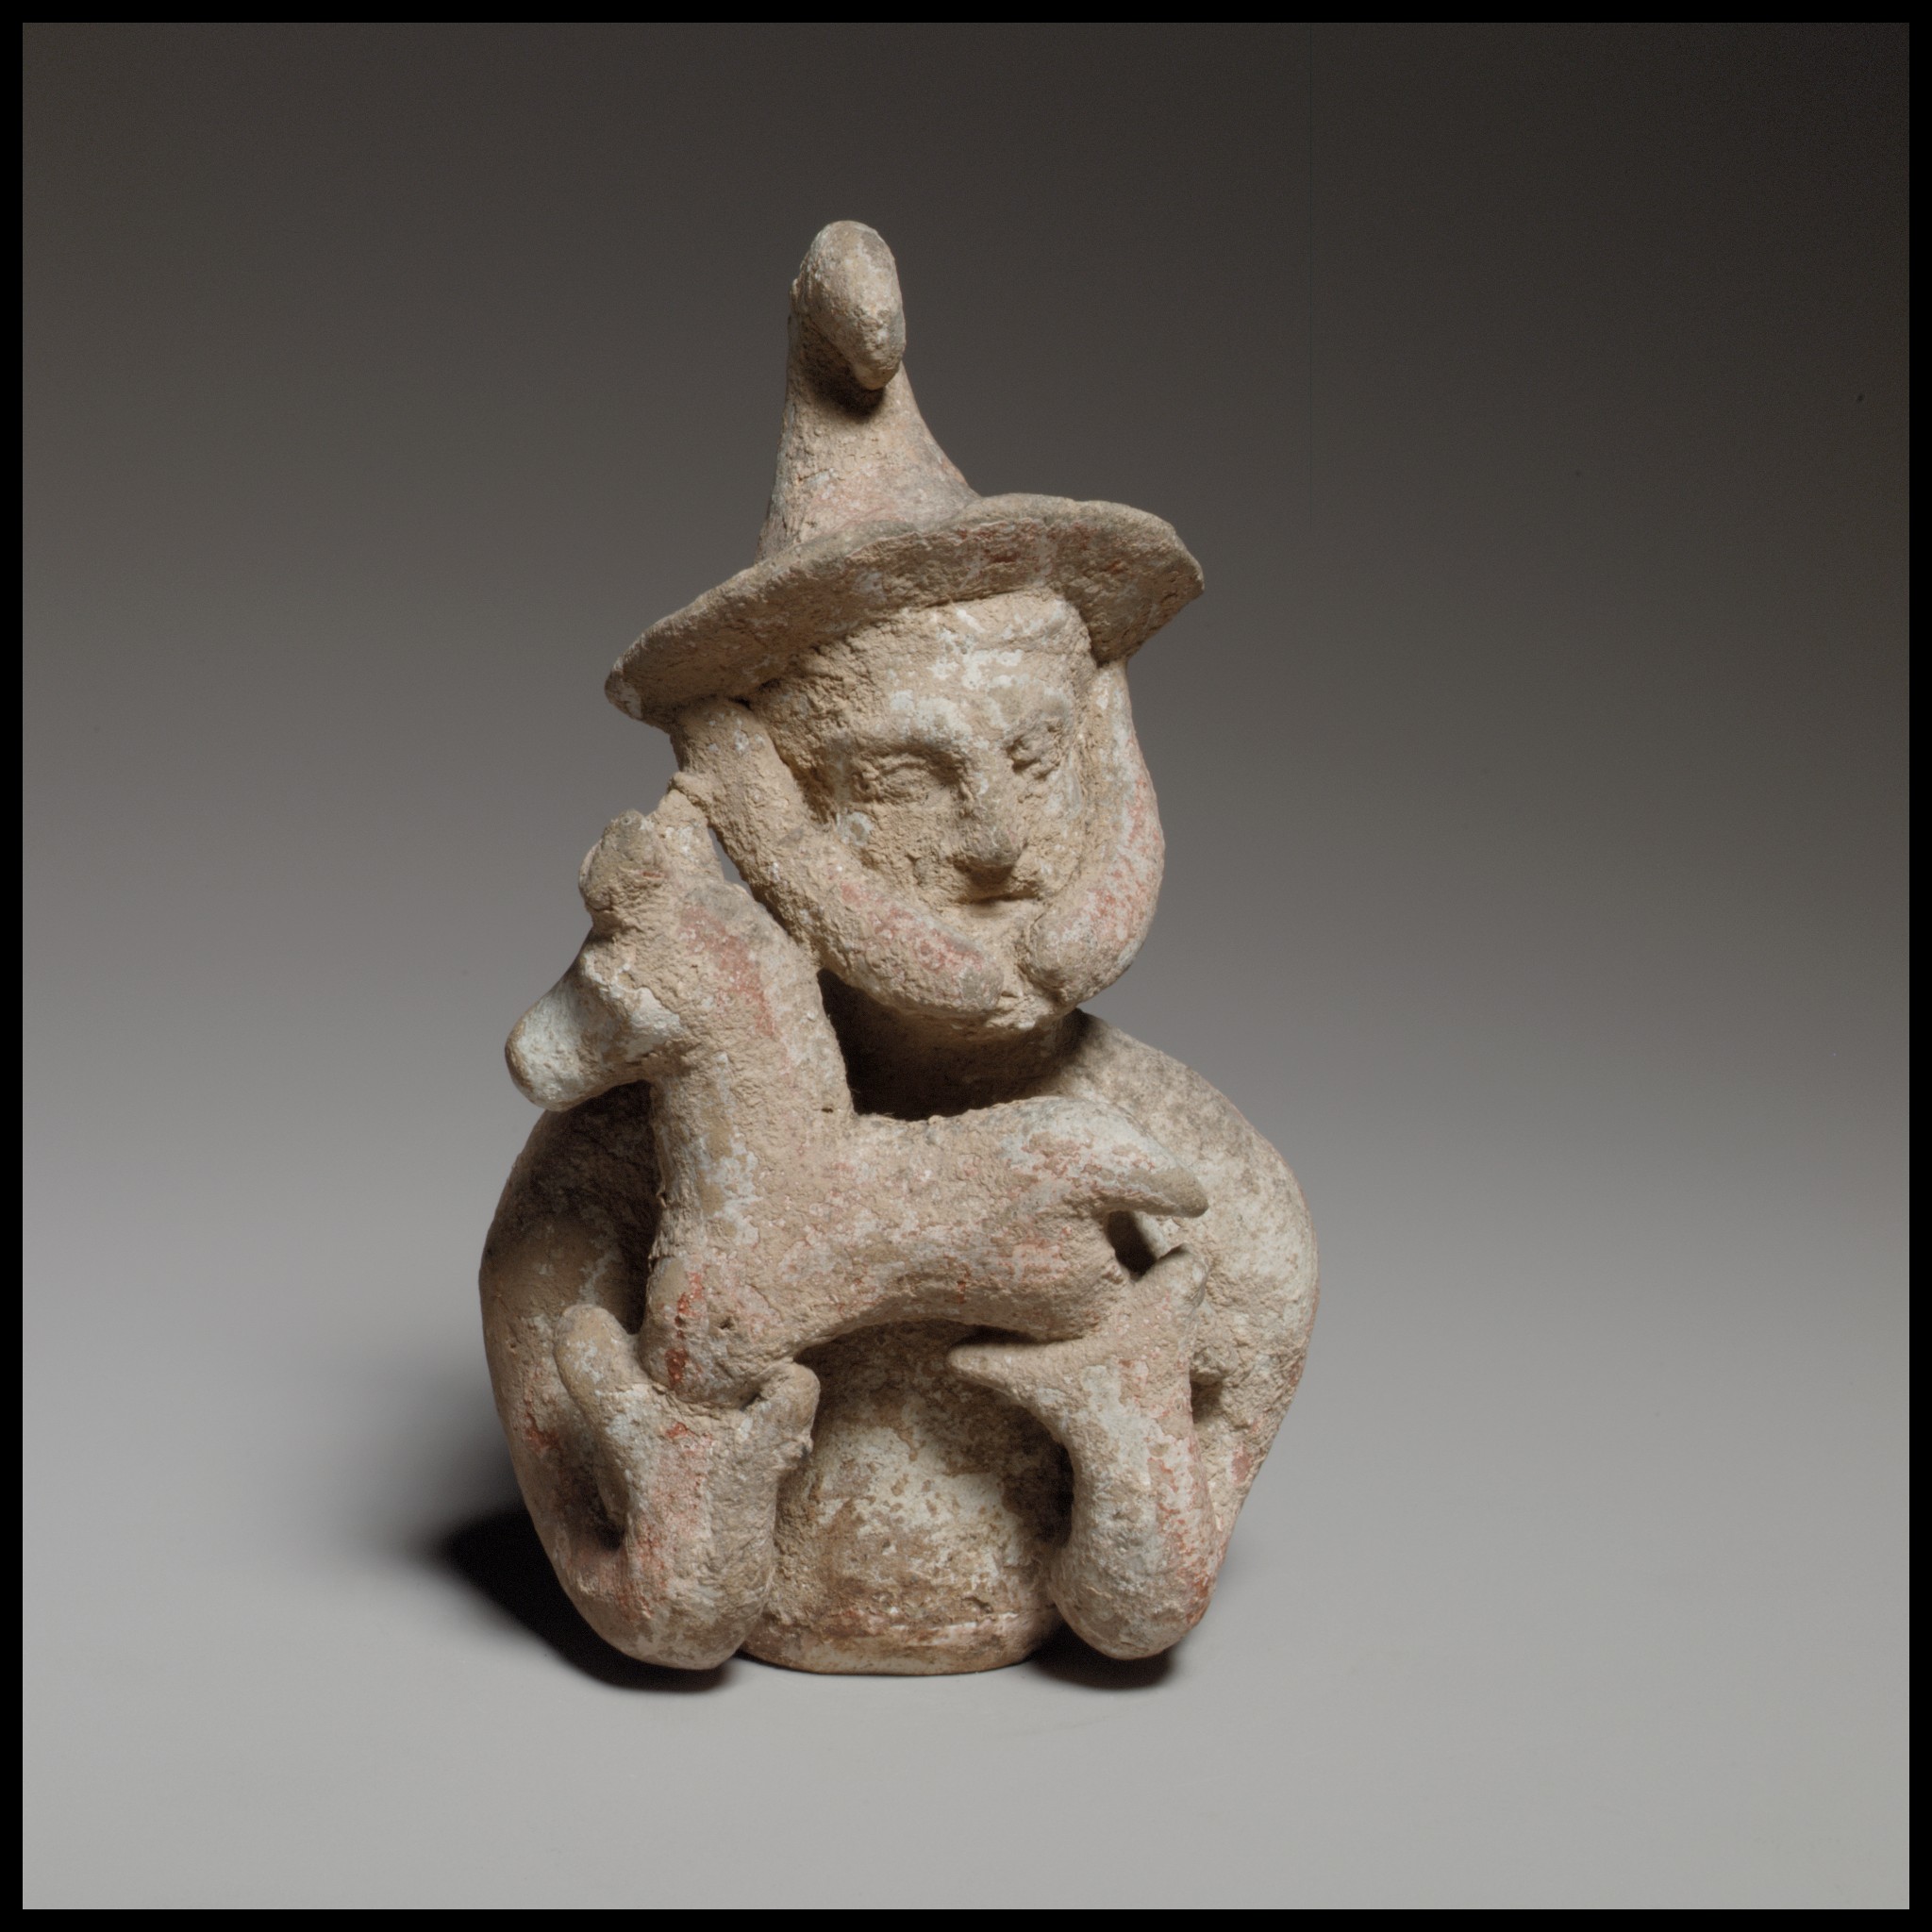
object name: statuette of a votary offering a child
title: Terracotta statuette of a male votary offering a kid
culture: cypriot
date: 400-301 BCE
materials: terracotta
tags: animals,men